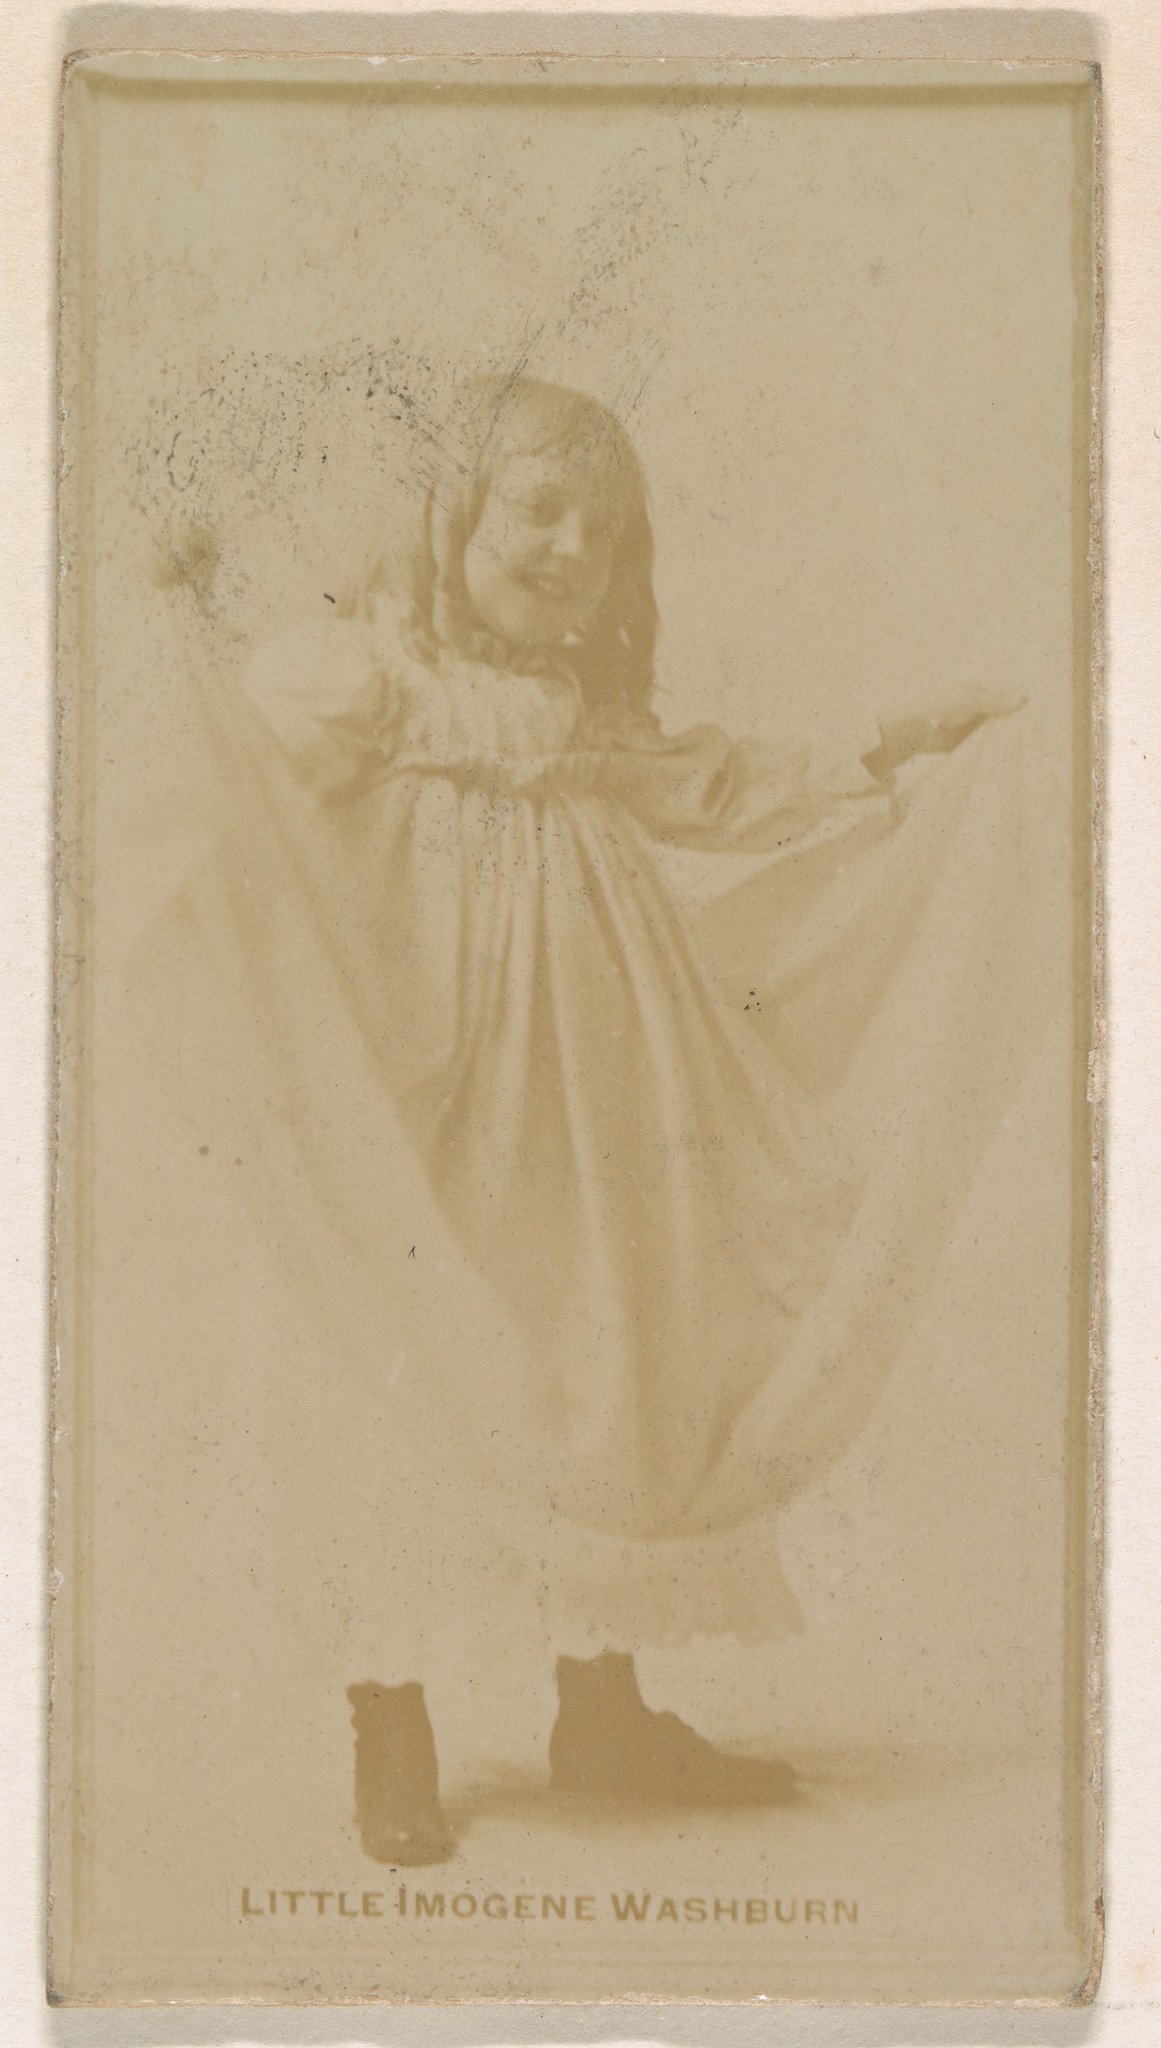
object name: photograph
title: Little Imogene Washburn, from the Actresses series (N245) issued by Kinney Brothers to promote Sweet Caporal Cigarettes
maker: kinney brothers tobacco company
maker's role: publisher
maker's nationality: american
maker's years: 1869-2011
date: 1890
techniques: albumen silver print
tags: girls,portraits,actresses